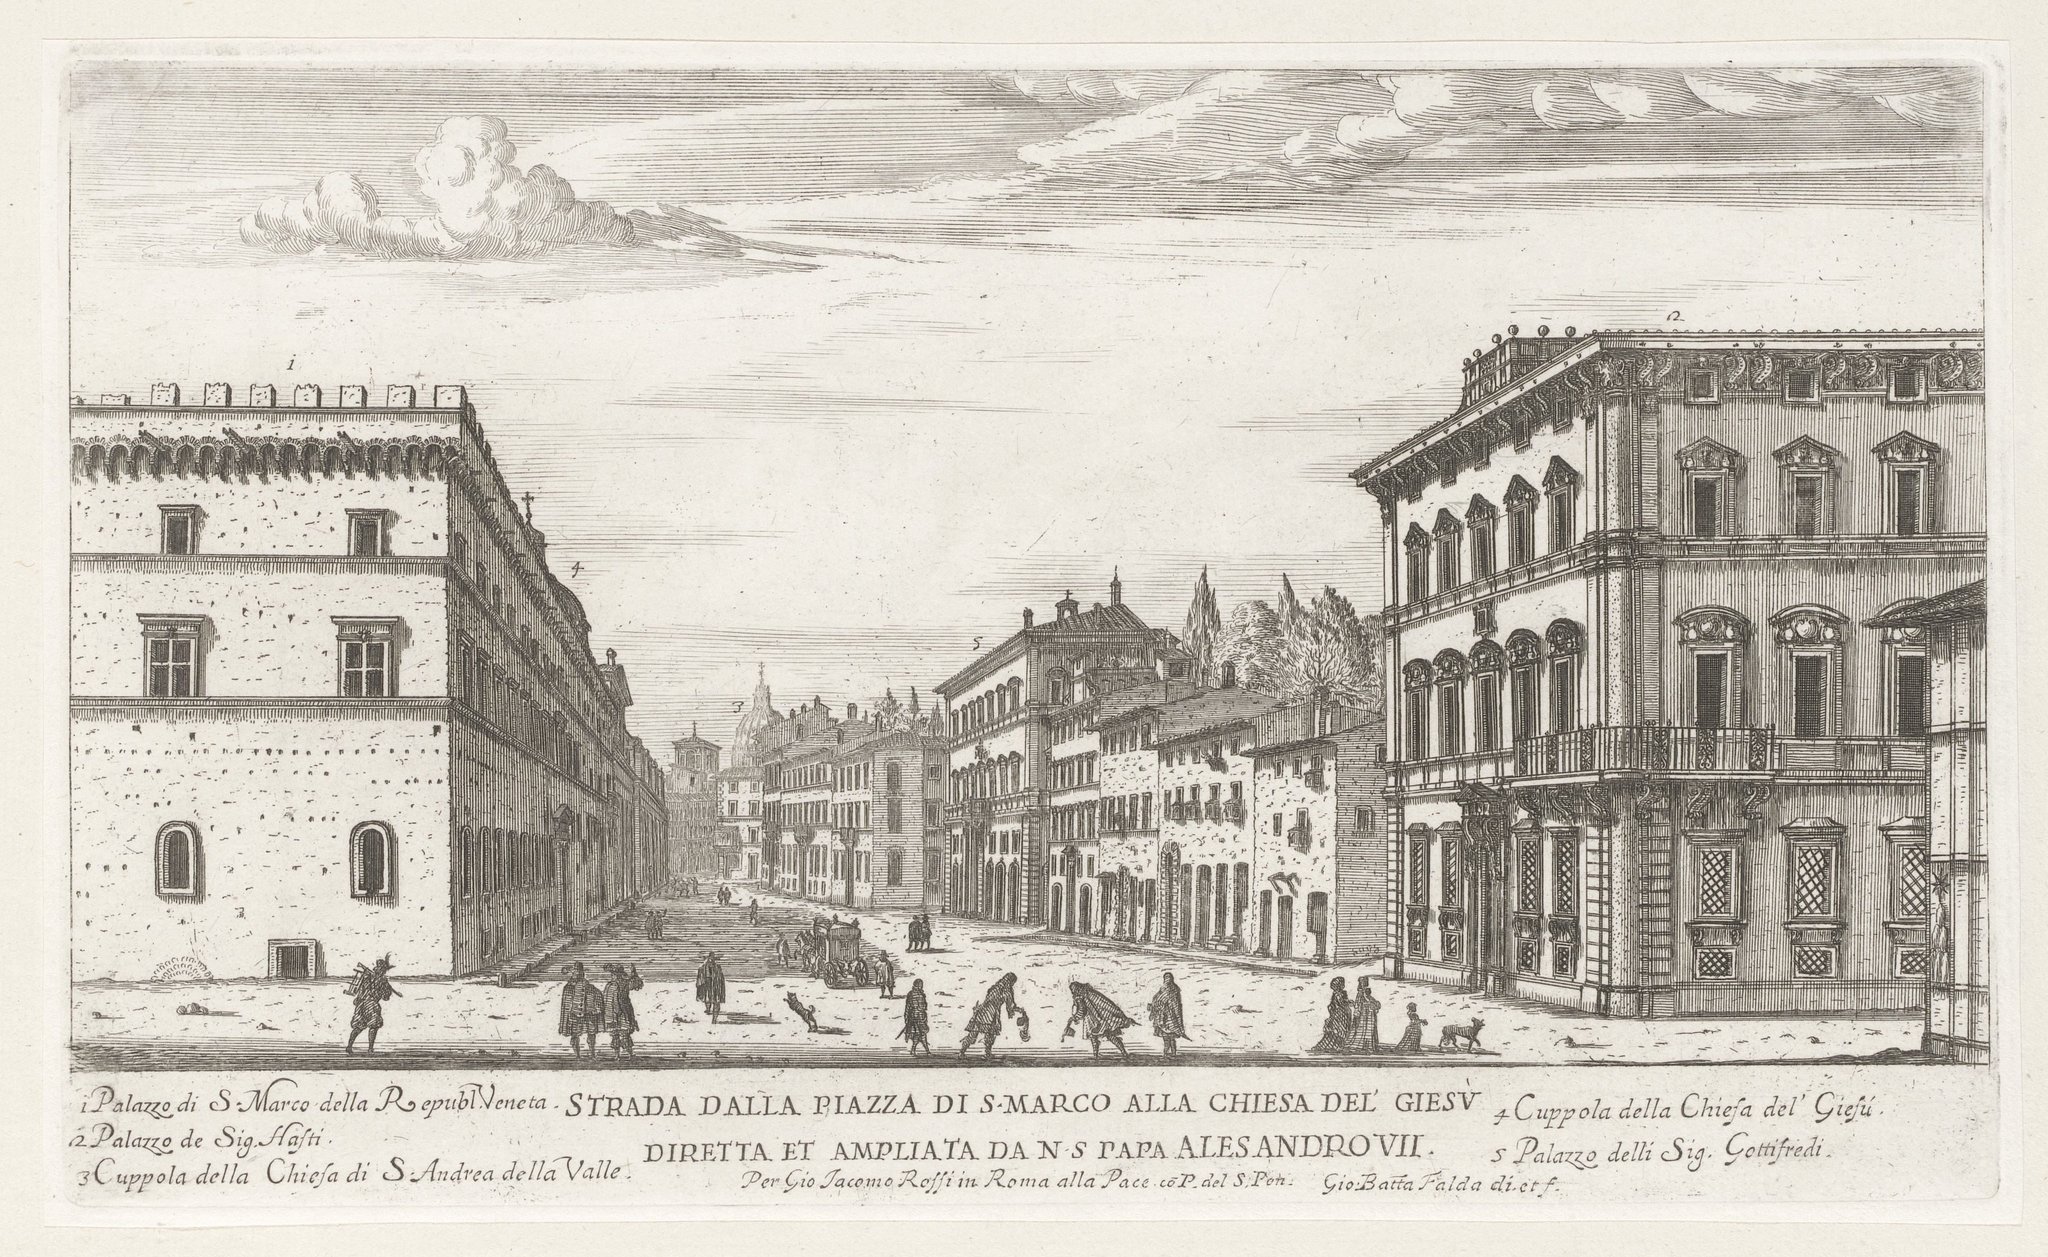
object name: print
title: Strada dalla Piazza di S. Marco alla Chiesa del' Giesù diretta et ampliata da N. S. papa Alesandro VII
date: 1665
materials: paper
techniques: etching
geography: rome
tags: city-view, and landscape with man-made constructions, church (exterior), hôtel, i.e. small palace in city, street, rome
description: Deze prent maakt deel uit van een reeks bestaande uit vijf delen, waarvan de eerste drie delen bestaan uit prenten van Giovanni Battista Falda. Deel één bevat 25 prenten (+ titelprent en opdracht) (1665), deel twee bevat 15 prenten (+ titelprent en opdracht) (1665-67) en deel drie bevat 38 prenten (+ titelprent en opdracht) (1669-70). Delen vier en vijf bevatten prenten door Alessandro Specchi en Giovanni Domenico Campiglia. De originele drukplaten voor de eerste drie delen worden bewaard in de Calcografia Nazionale in Rome (inv. nr. 1414).